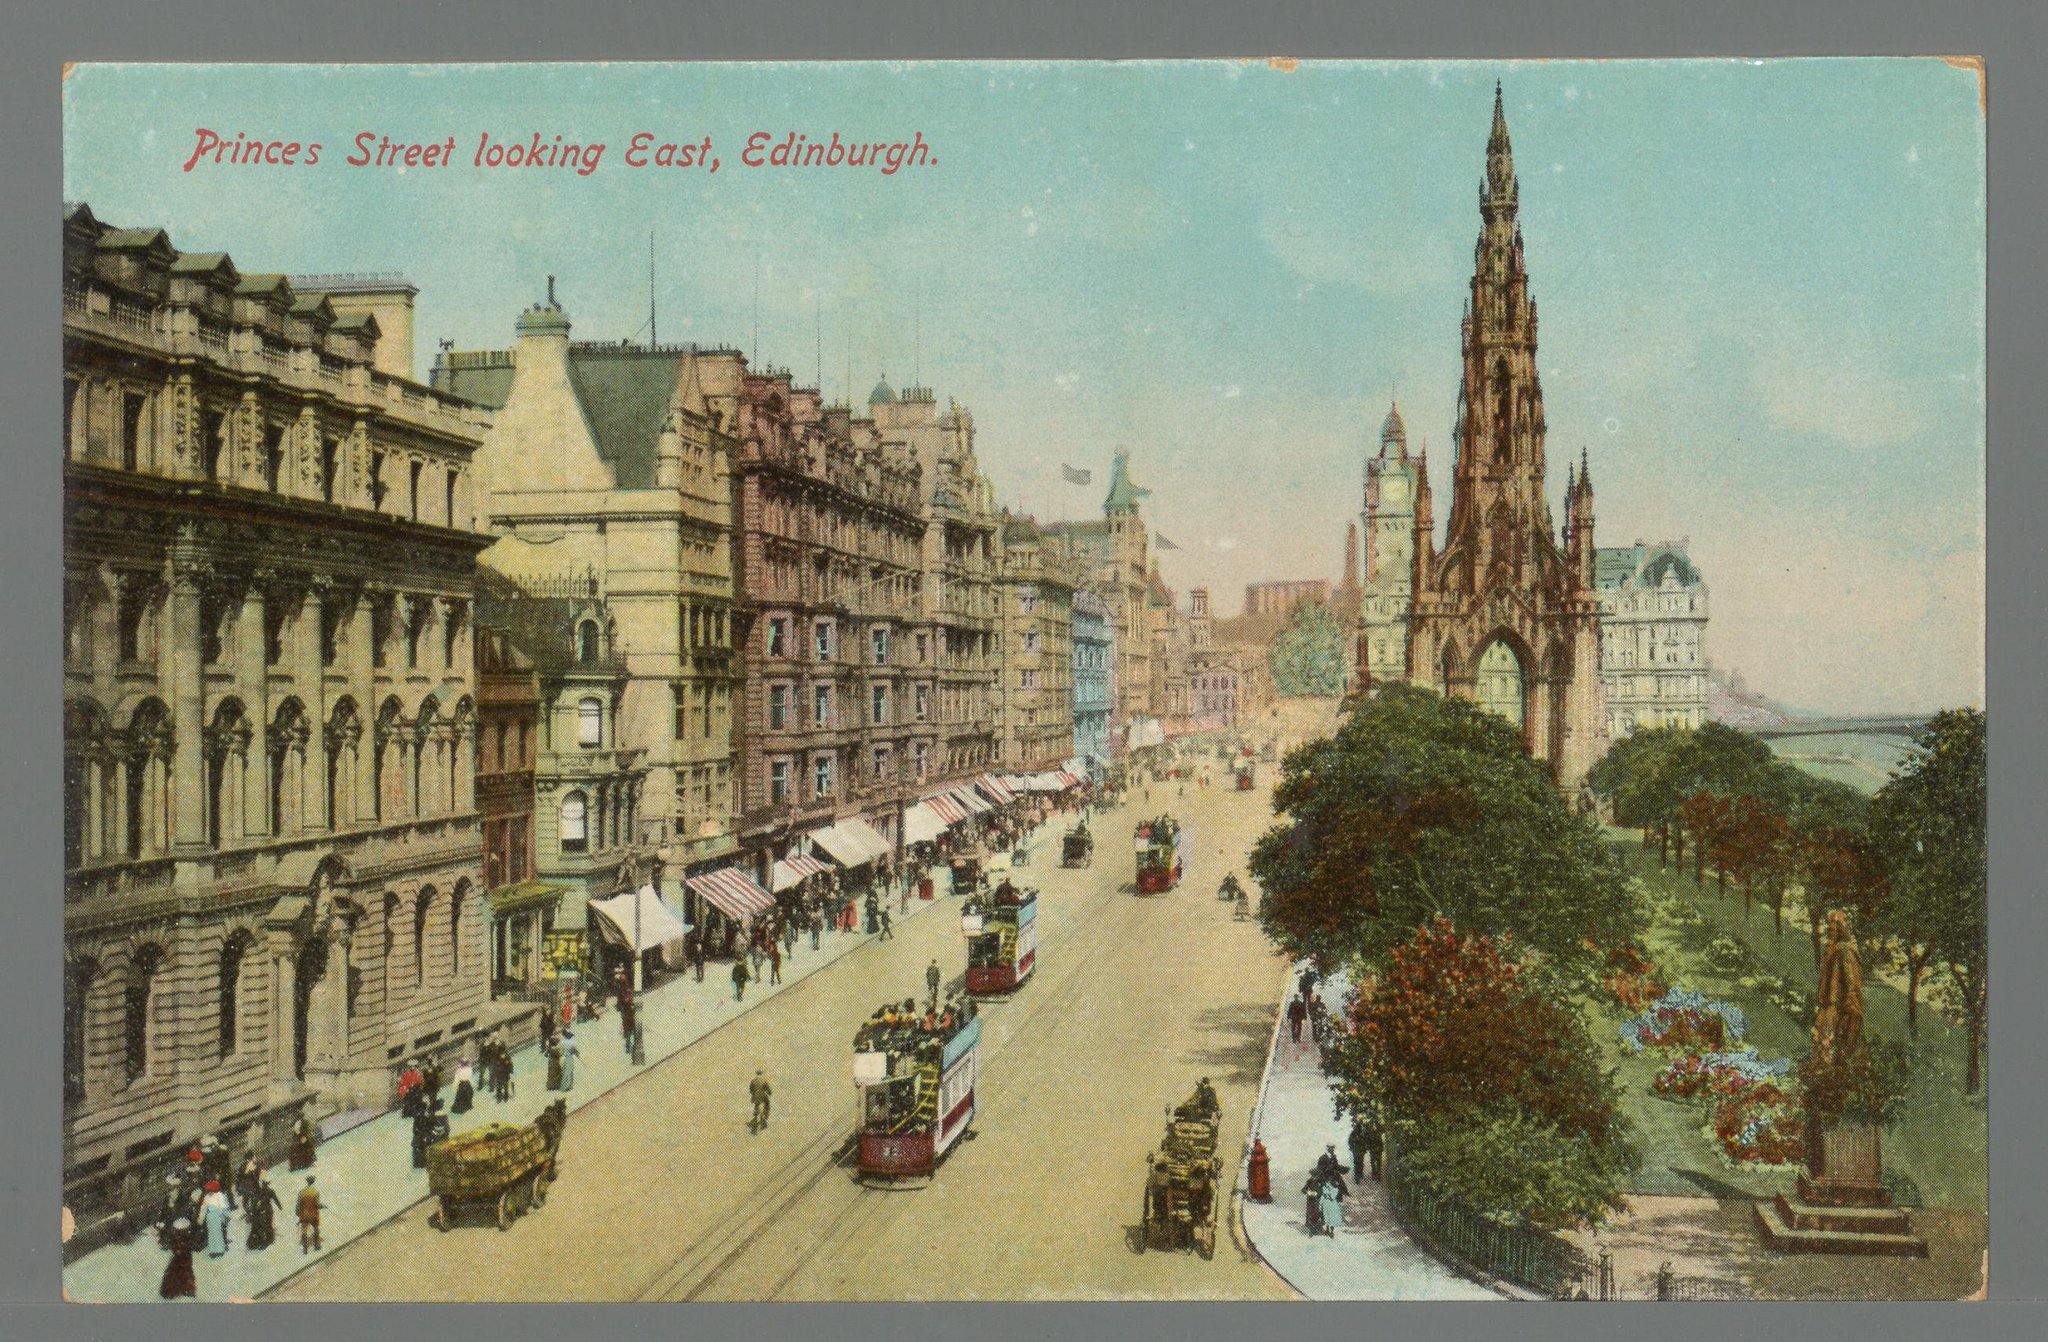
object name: ansichtkaart, prentbriefkaart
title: Princes Street looking East, Edinburgh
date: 1902-1930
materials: cardboard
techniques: lithograph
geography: edinburgh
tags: monument, statue, street